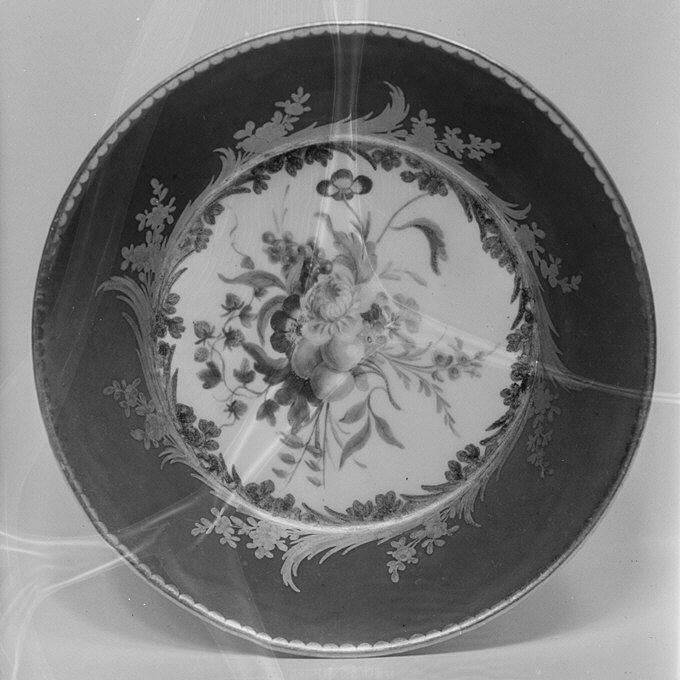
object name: saucer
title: Saucer (one of nine) (part of a service)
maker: sèvres manufactory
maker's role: manufactory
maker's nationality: french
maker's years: 1740-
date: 1786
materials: soft paste porcelain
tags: flowers